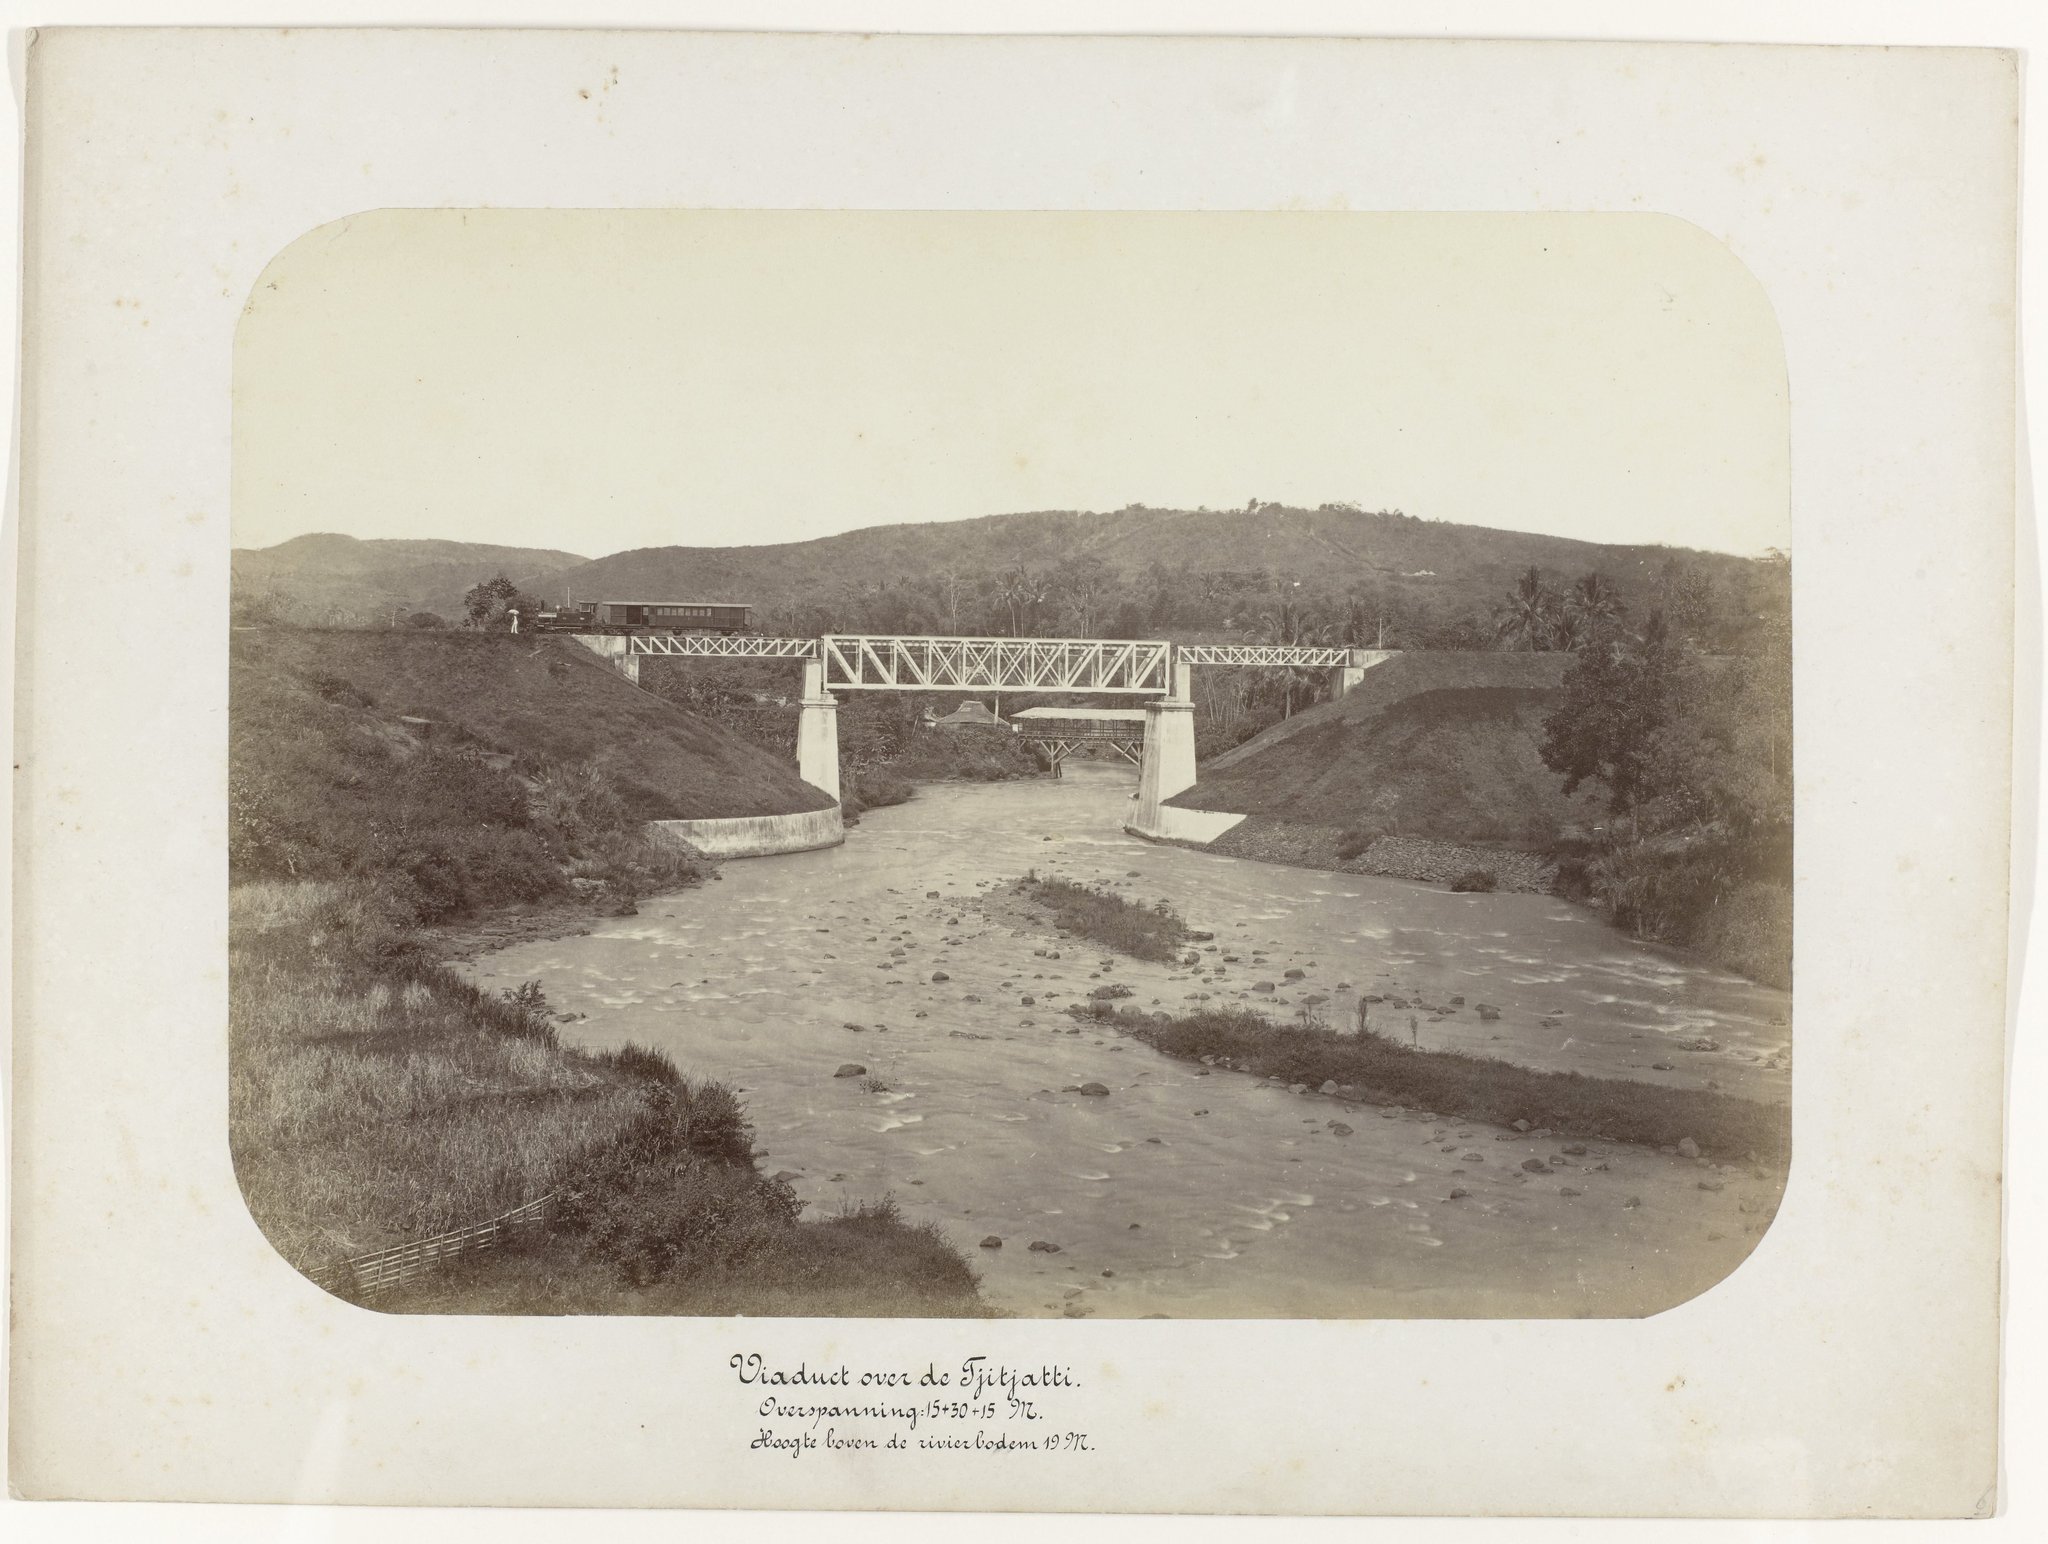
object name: photograph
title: Staatsspoorwegen op Java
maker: Anonymous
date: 1880-1888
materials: photographic support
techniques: albumen print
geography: java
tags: java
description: De viaduct of spoorbrug over de Tjitjatti. Links van de brug wacht de trein. Onderdeel van een groep van 62 foto's in een doos met het opschrift "Staatsspoorwegen op Java" uit 1888.